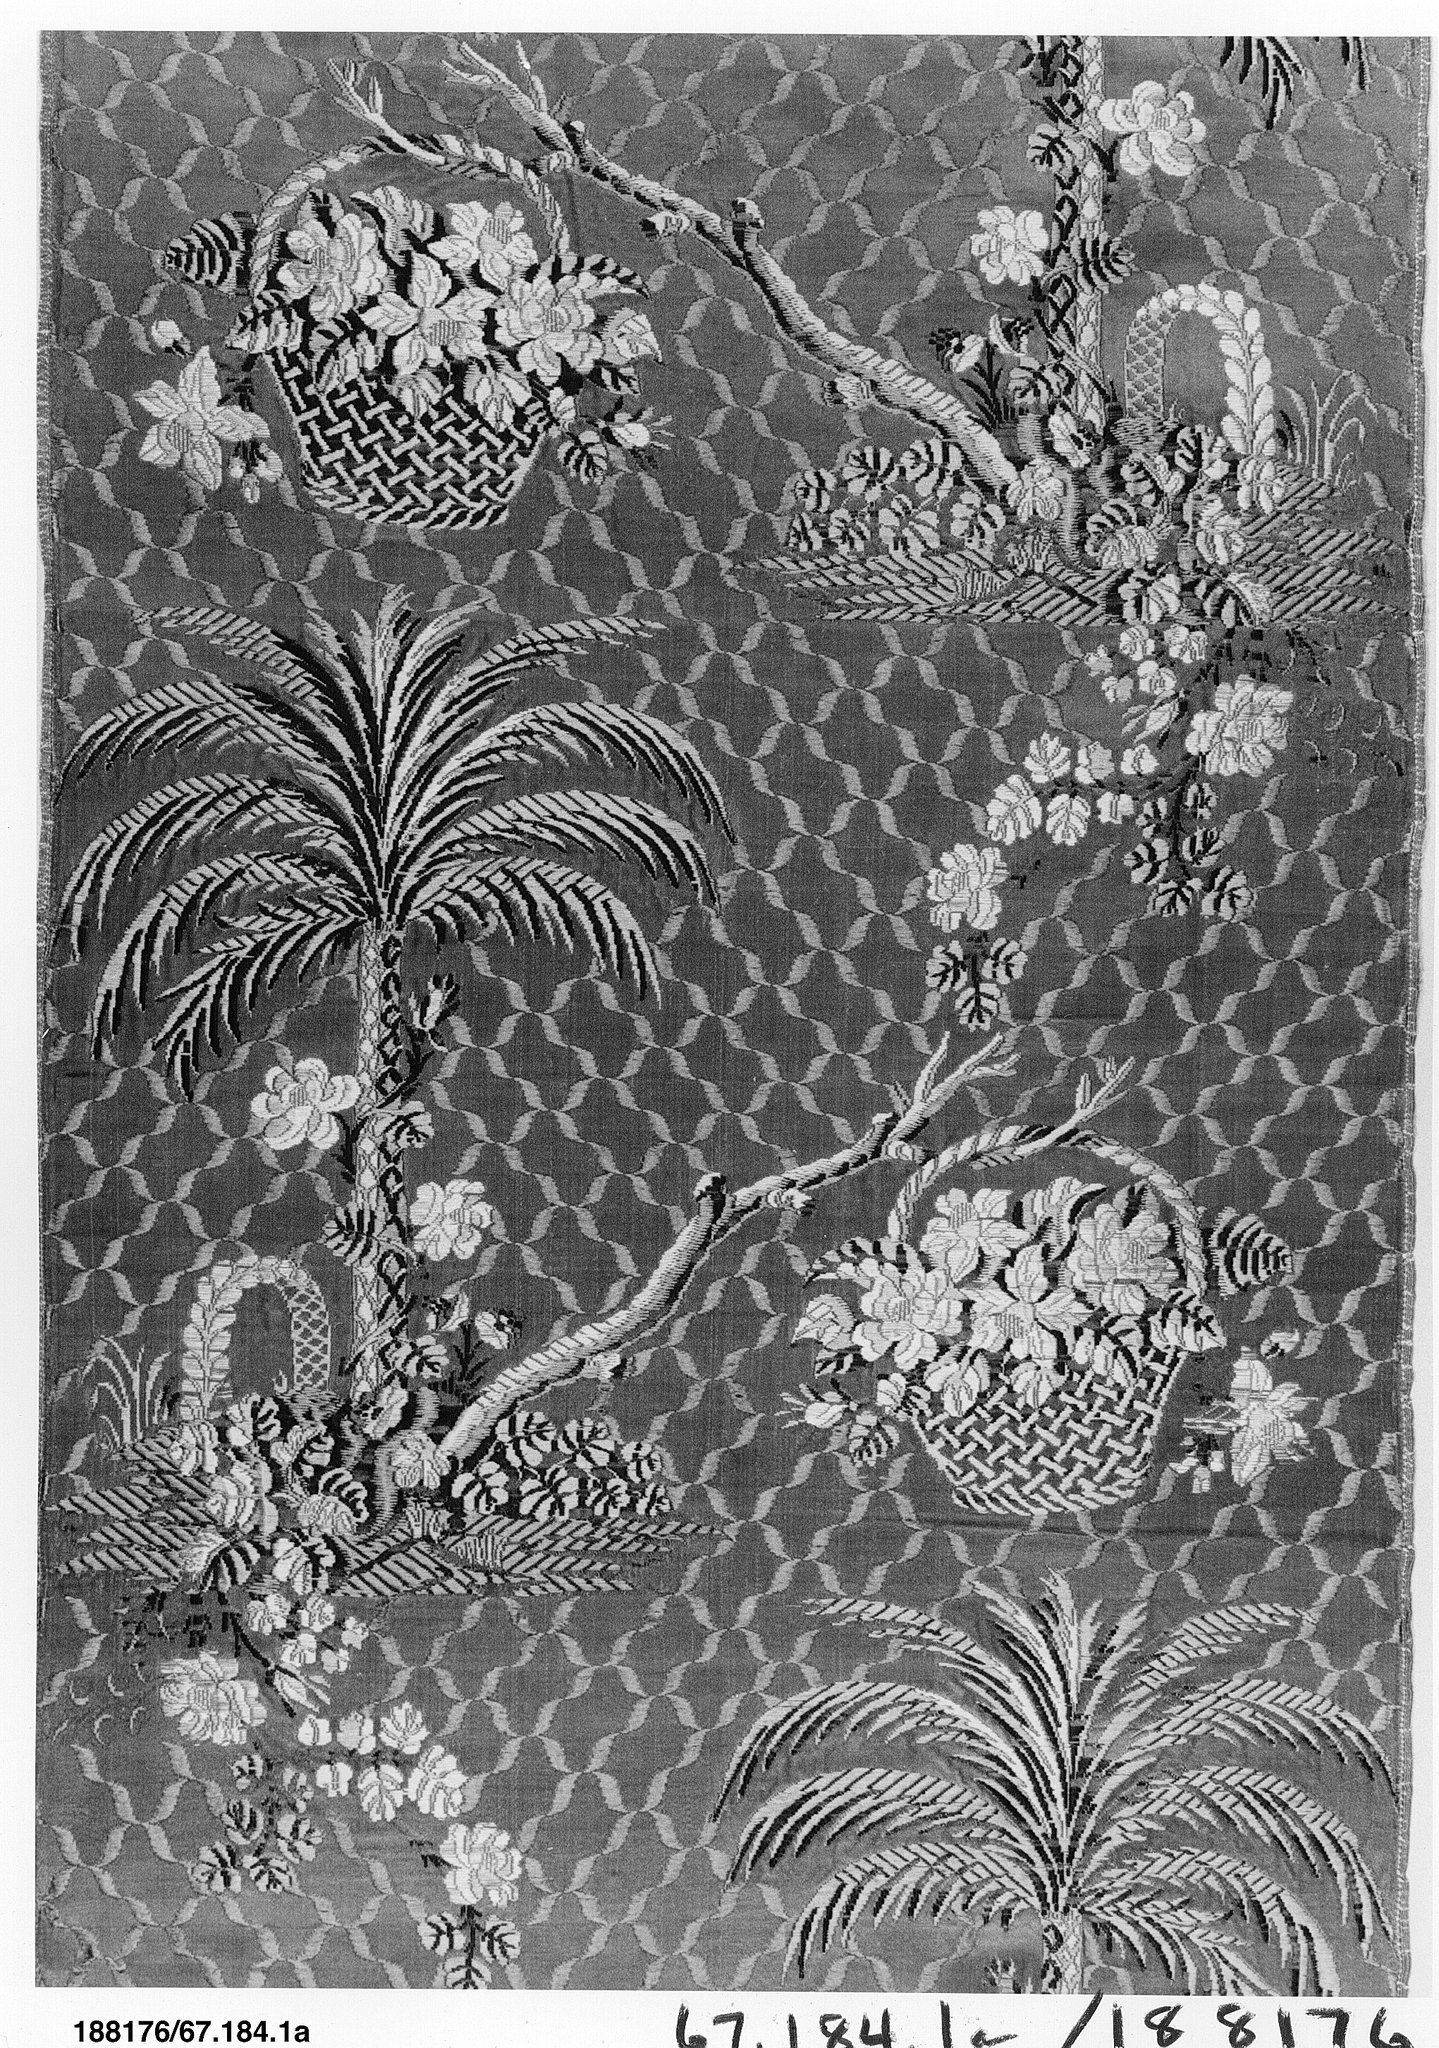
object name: piece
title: Pieces (8)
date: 1701-1800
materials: silk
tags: flowers,trees